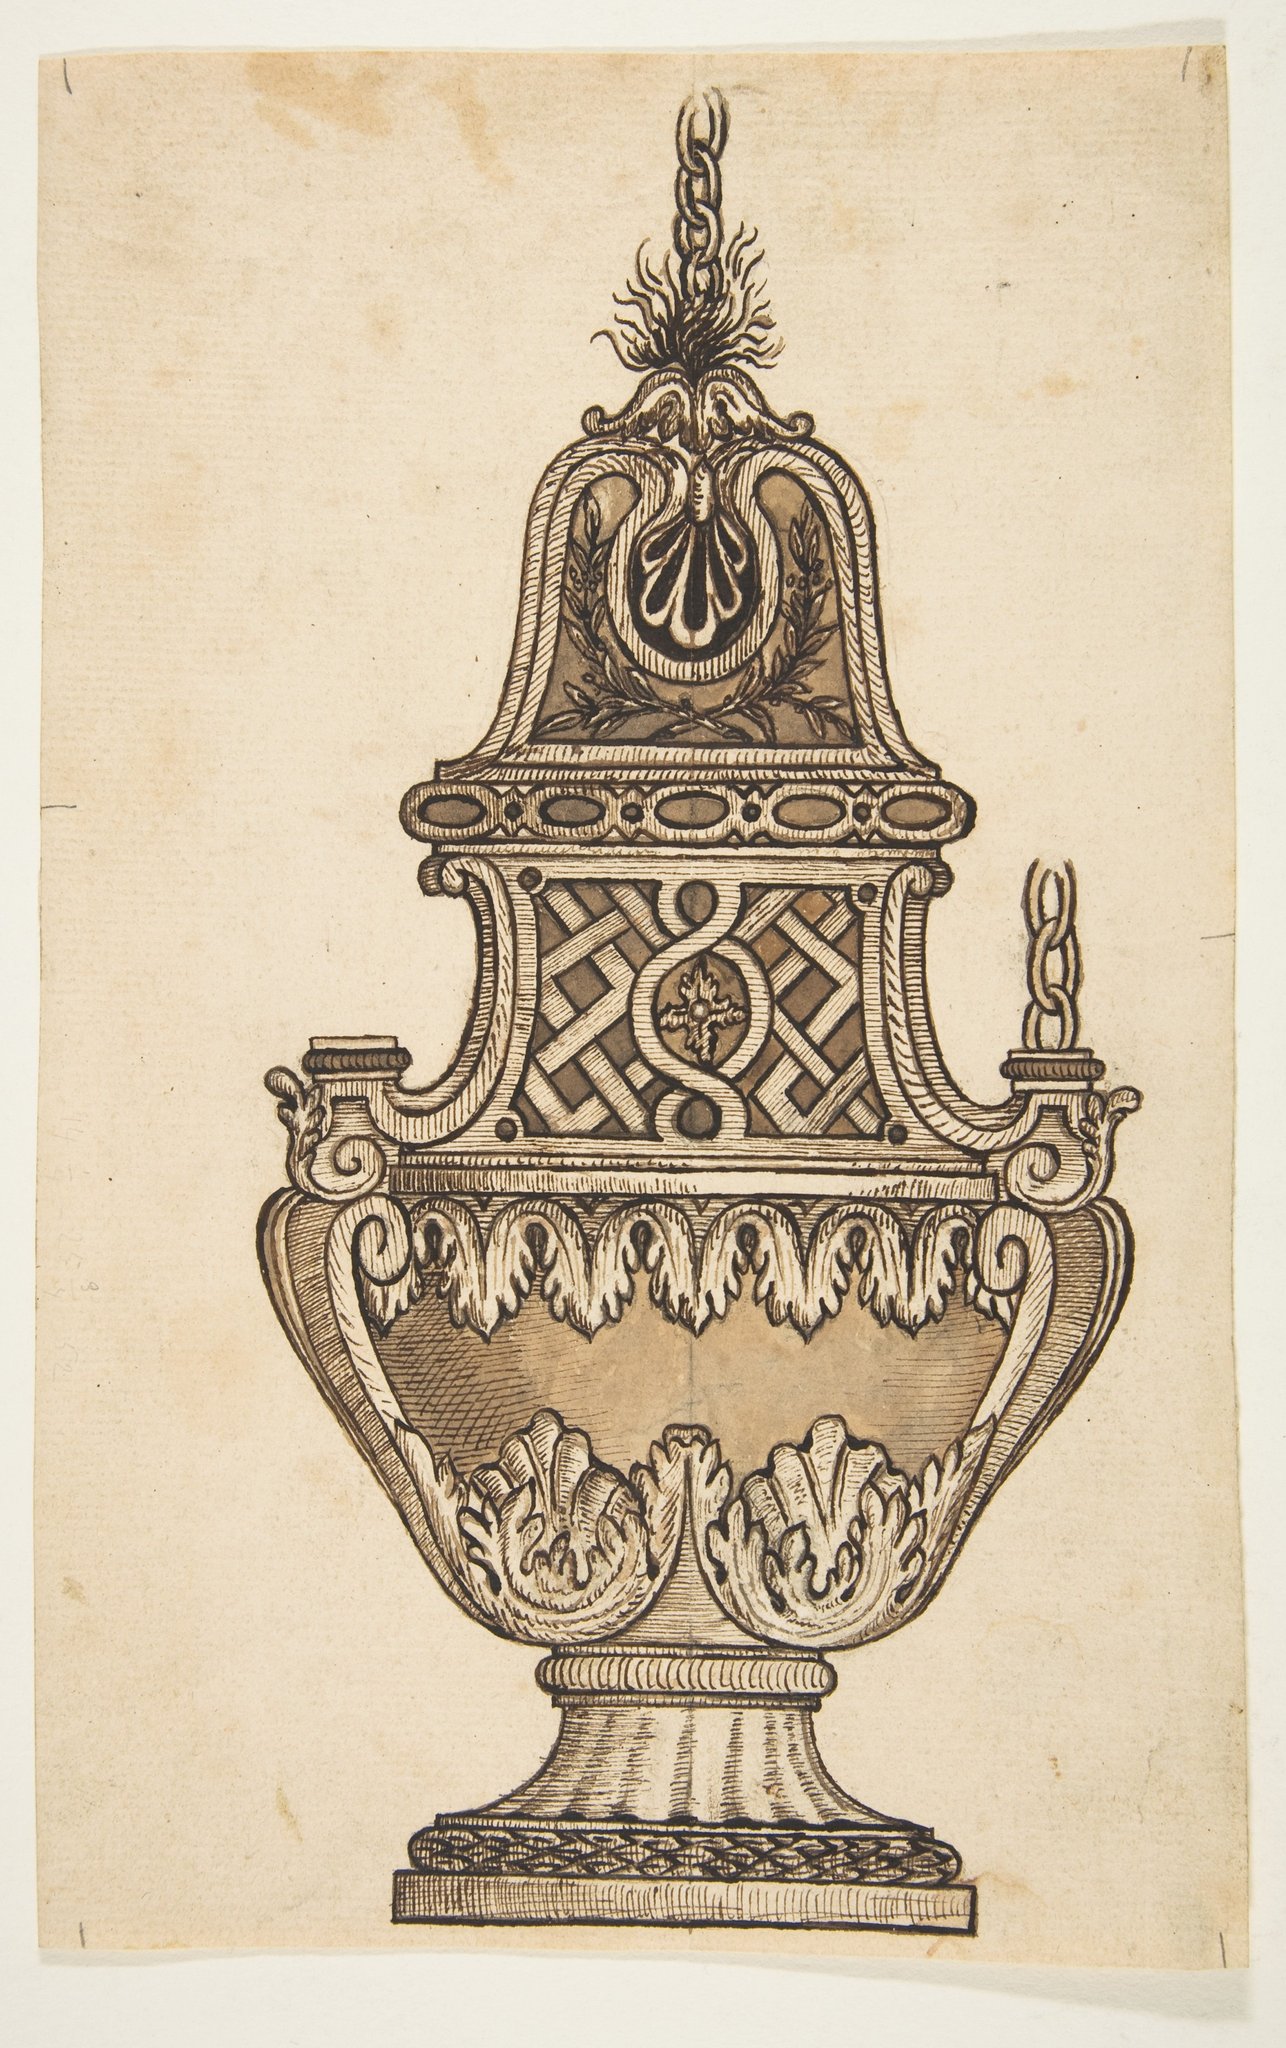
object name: drawing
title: Design for a Vessel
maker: anonymous, french, 19th century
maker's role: artist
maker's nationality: french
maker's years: 1800-1900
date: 1801-1900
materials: ink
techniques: pen, wash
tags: vessels